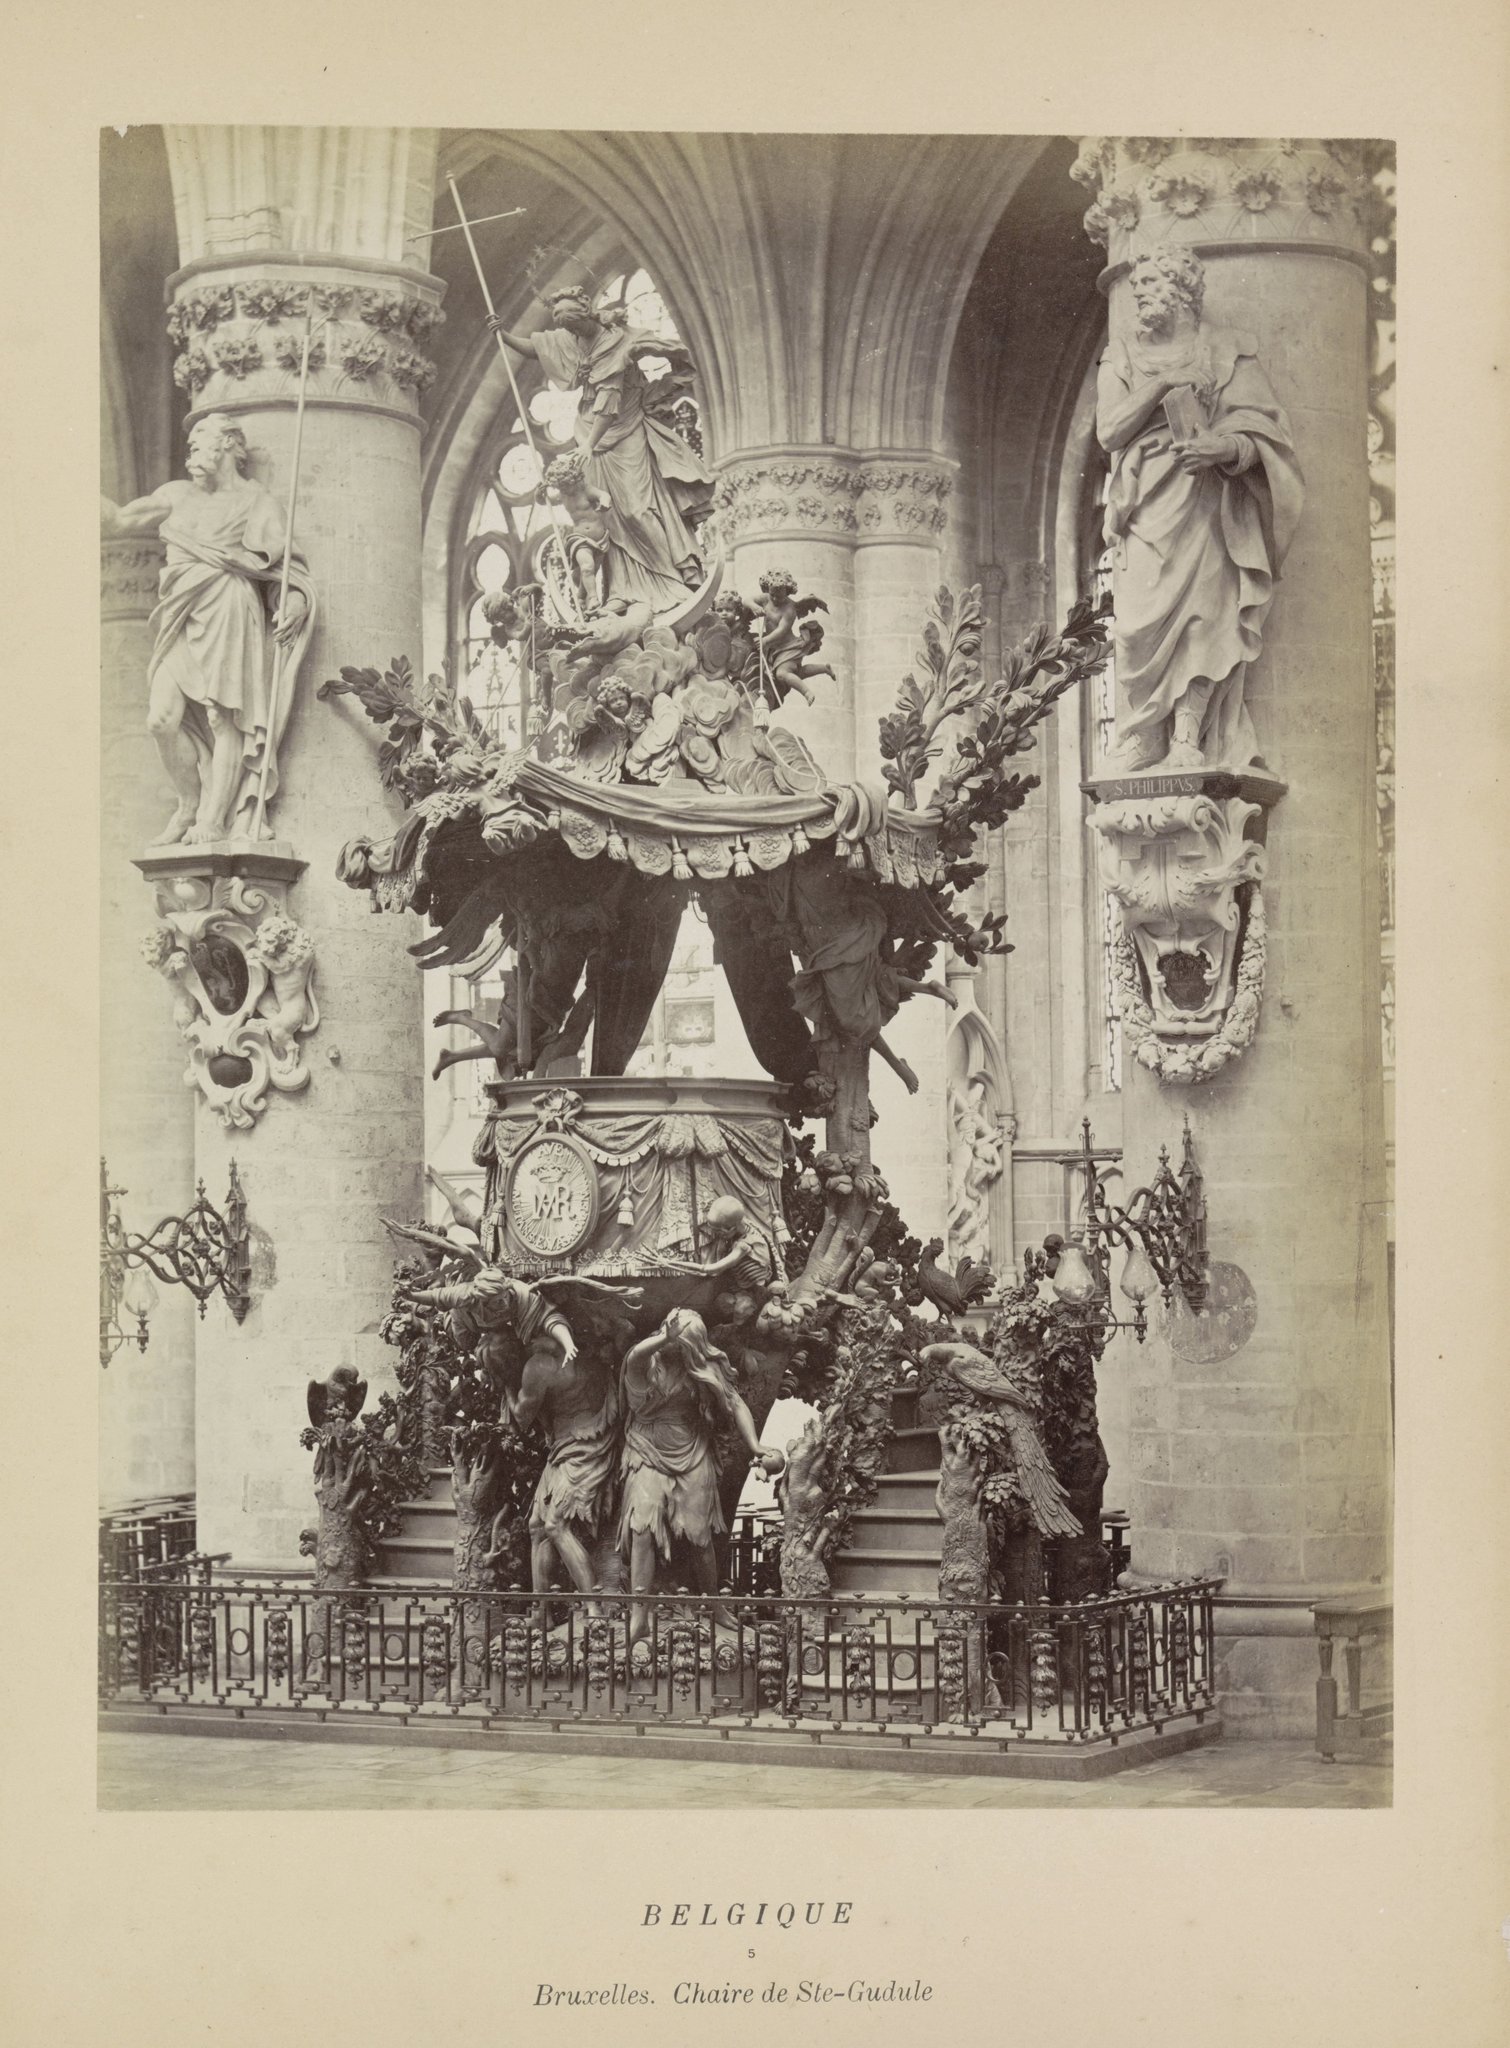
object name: photograph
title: Preekstoel in de Sint-Michiel-en-Sint-Goedelekathedraal in Brussel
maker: Anonymous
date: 1885-1900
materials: paper, photographic support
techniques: albumen print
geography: france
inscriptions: caption: ‘Belgique / 5 / Bruxelles. Chaire de Ste-Gudule’